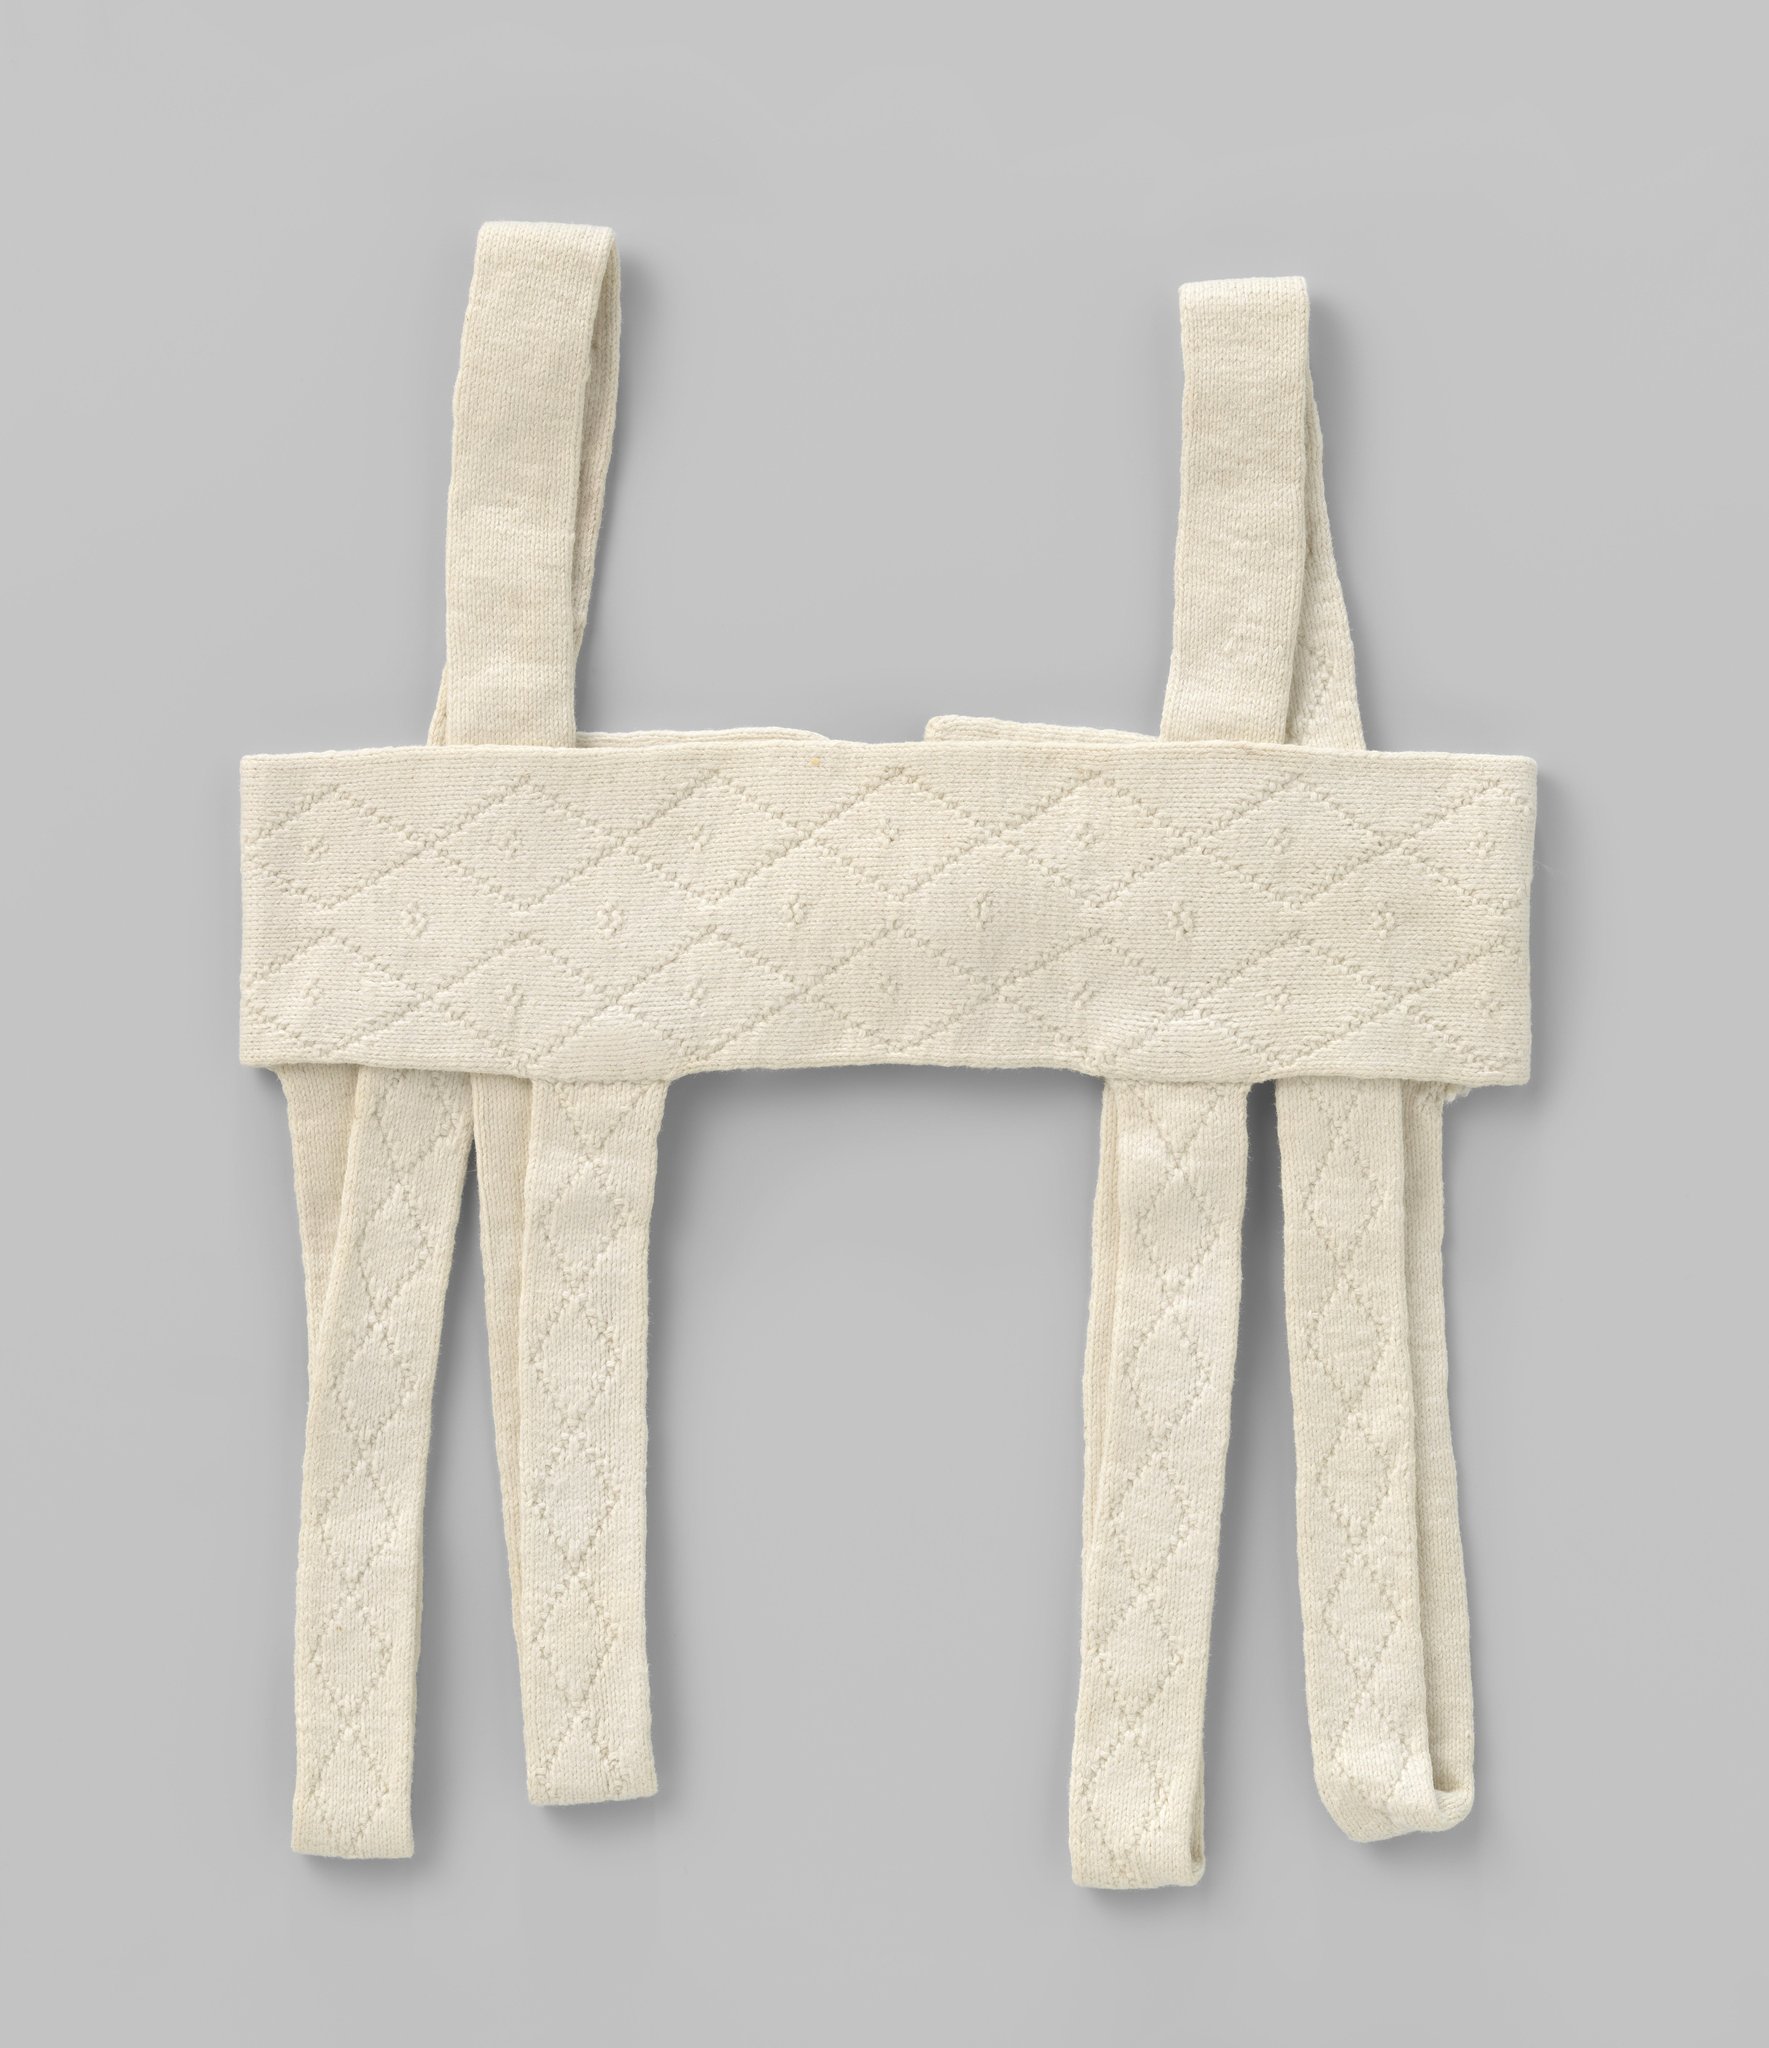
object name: leiband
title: Gebreide witte leiband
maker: Anonymous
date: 1800-1899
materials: textile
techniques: knitting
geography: netherlands